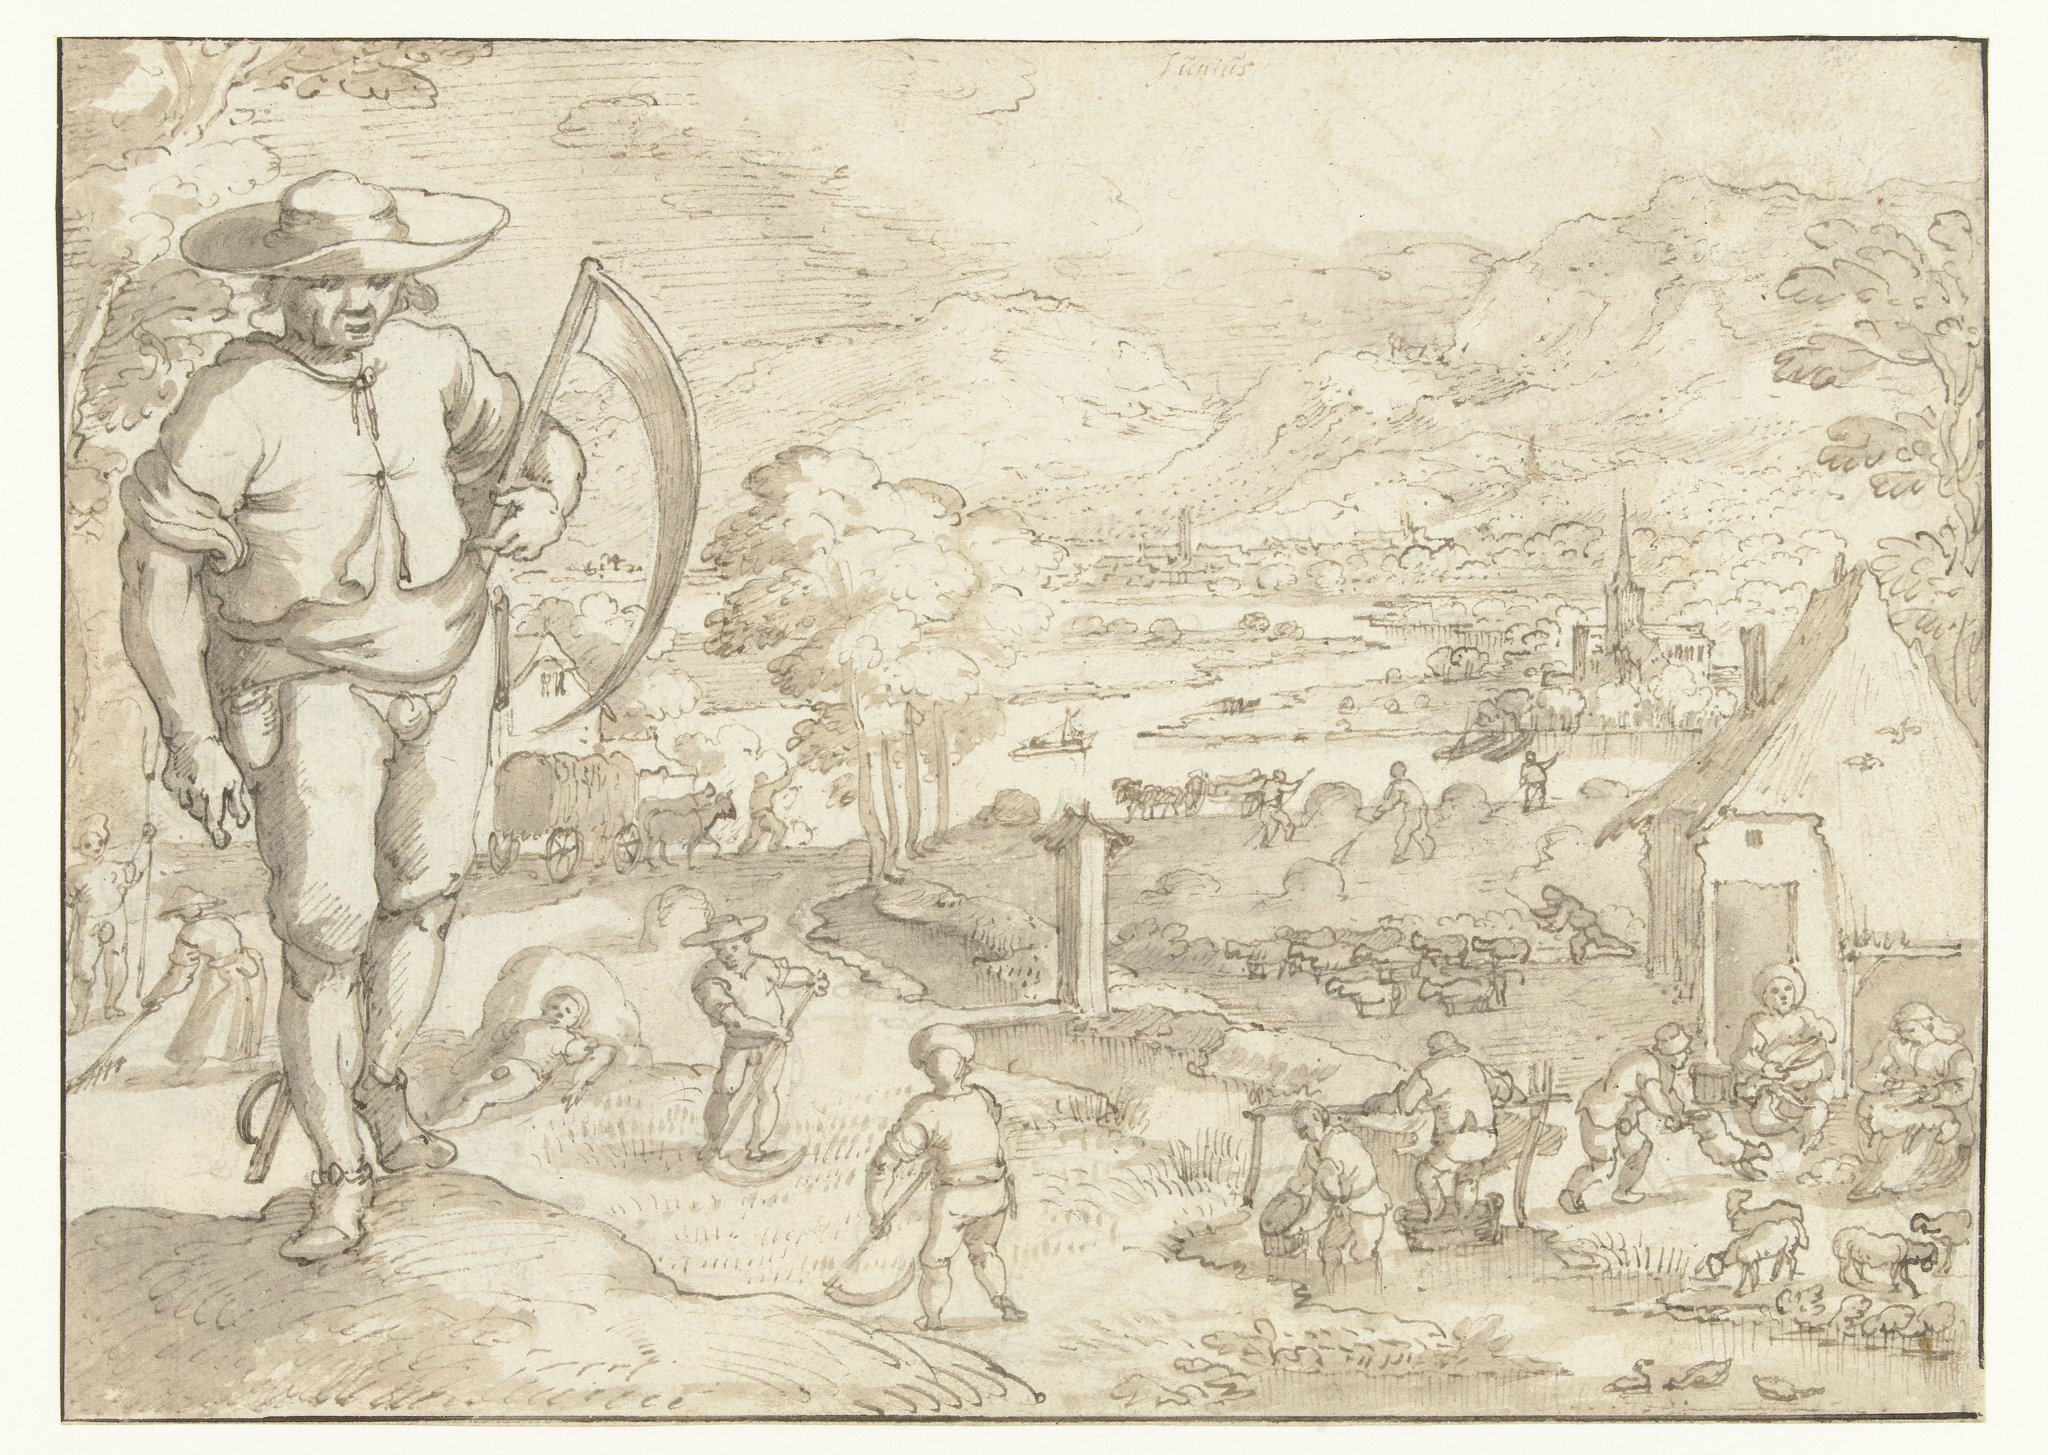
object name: drawing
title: Junius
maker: joos de momper (ii)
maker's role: draughtsman, painter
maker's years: 1564-1635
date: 1590-1610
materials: chalk, ink, paper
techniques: brush, pen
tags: agricultural implements: scythe, june and its 'labours', agriculture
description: De maand juni. Landschap met oogstende en schapen scherende mensen, links op de voorgrond staat een man met een zeis. Ontwerp voor een prent.